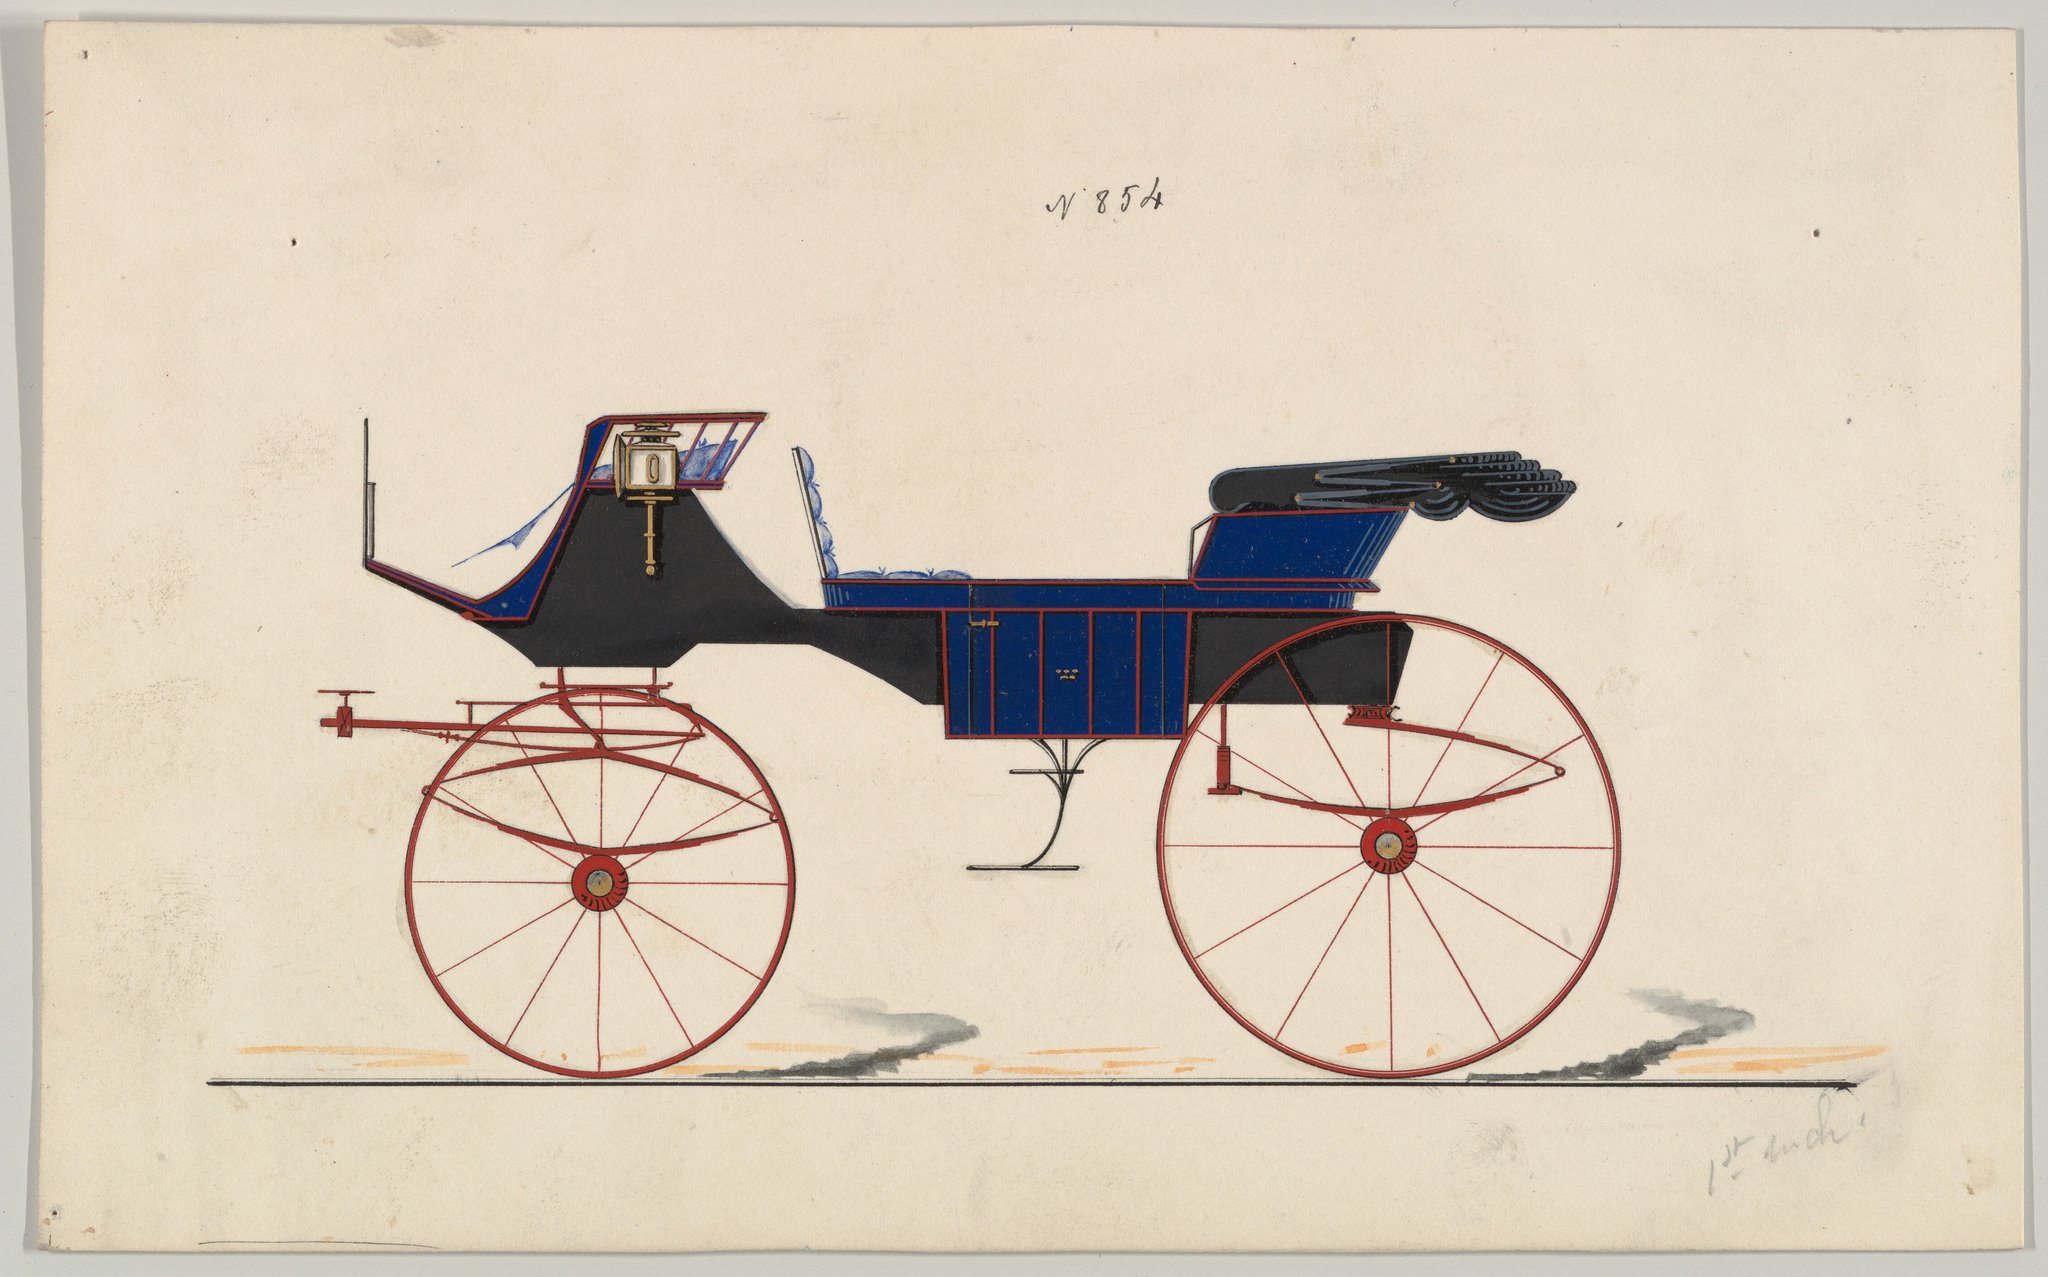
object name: drawing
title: Design for Vis-à-vis, no. 854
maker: brewster & co.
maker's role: manufacturer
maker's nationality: american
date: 1870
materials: gouache, gum arabic, ink, watercolor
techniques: pen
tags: carriages